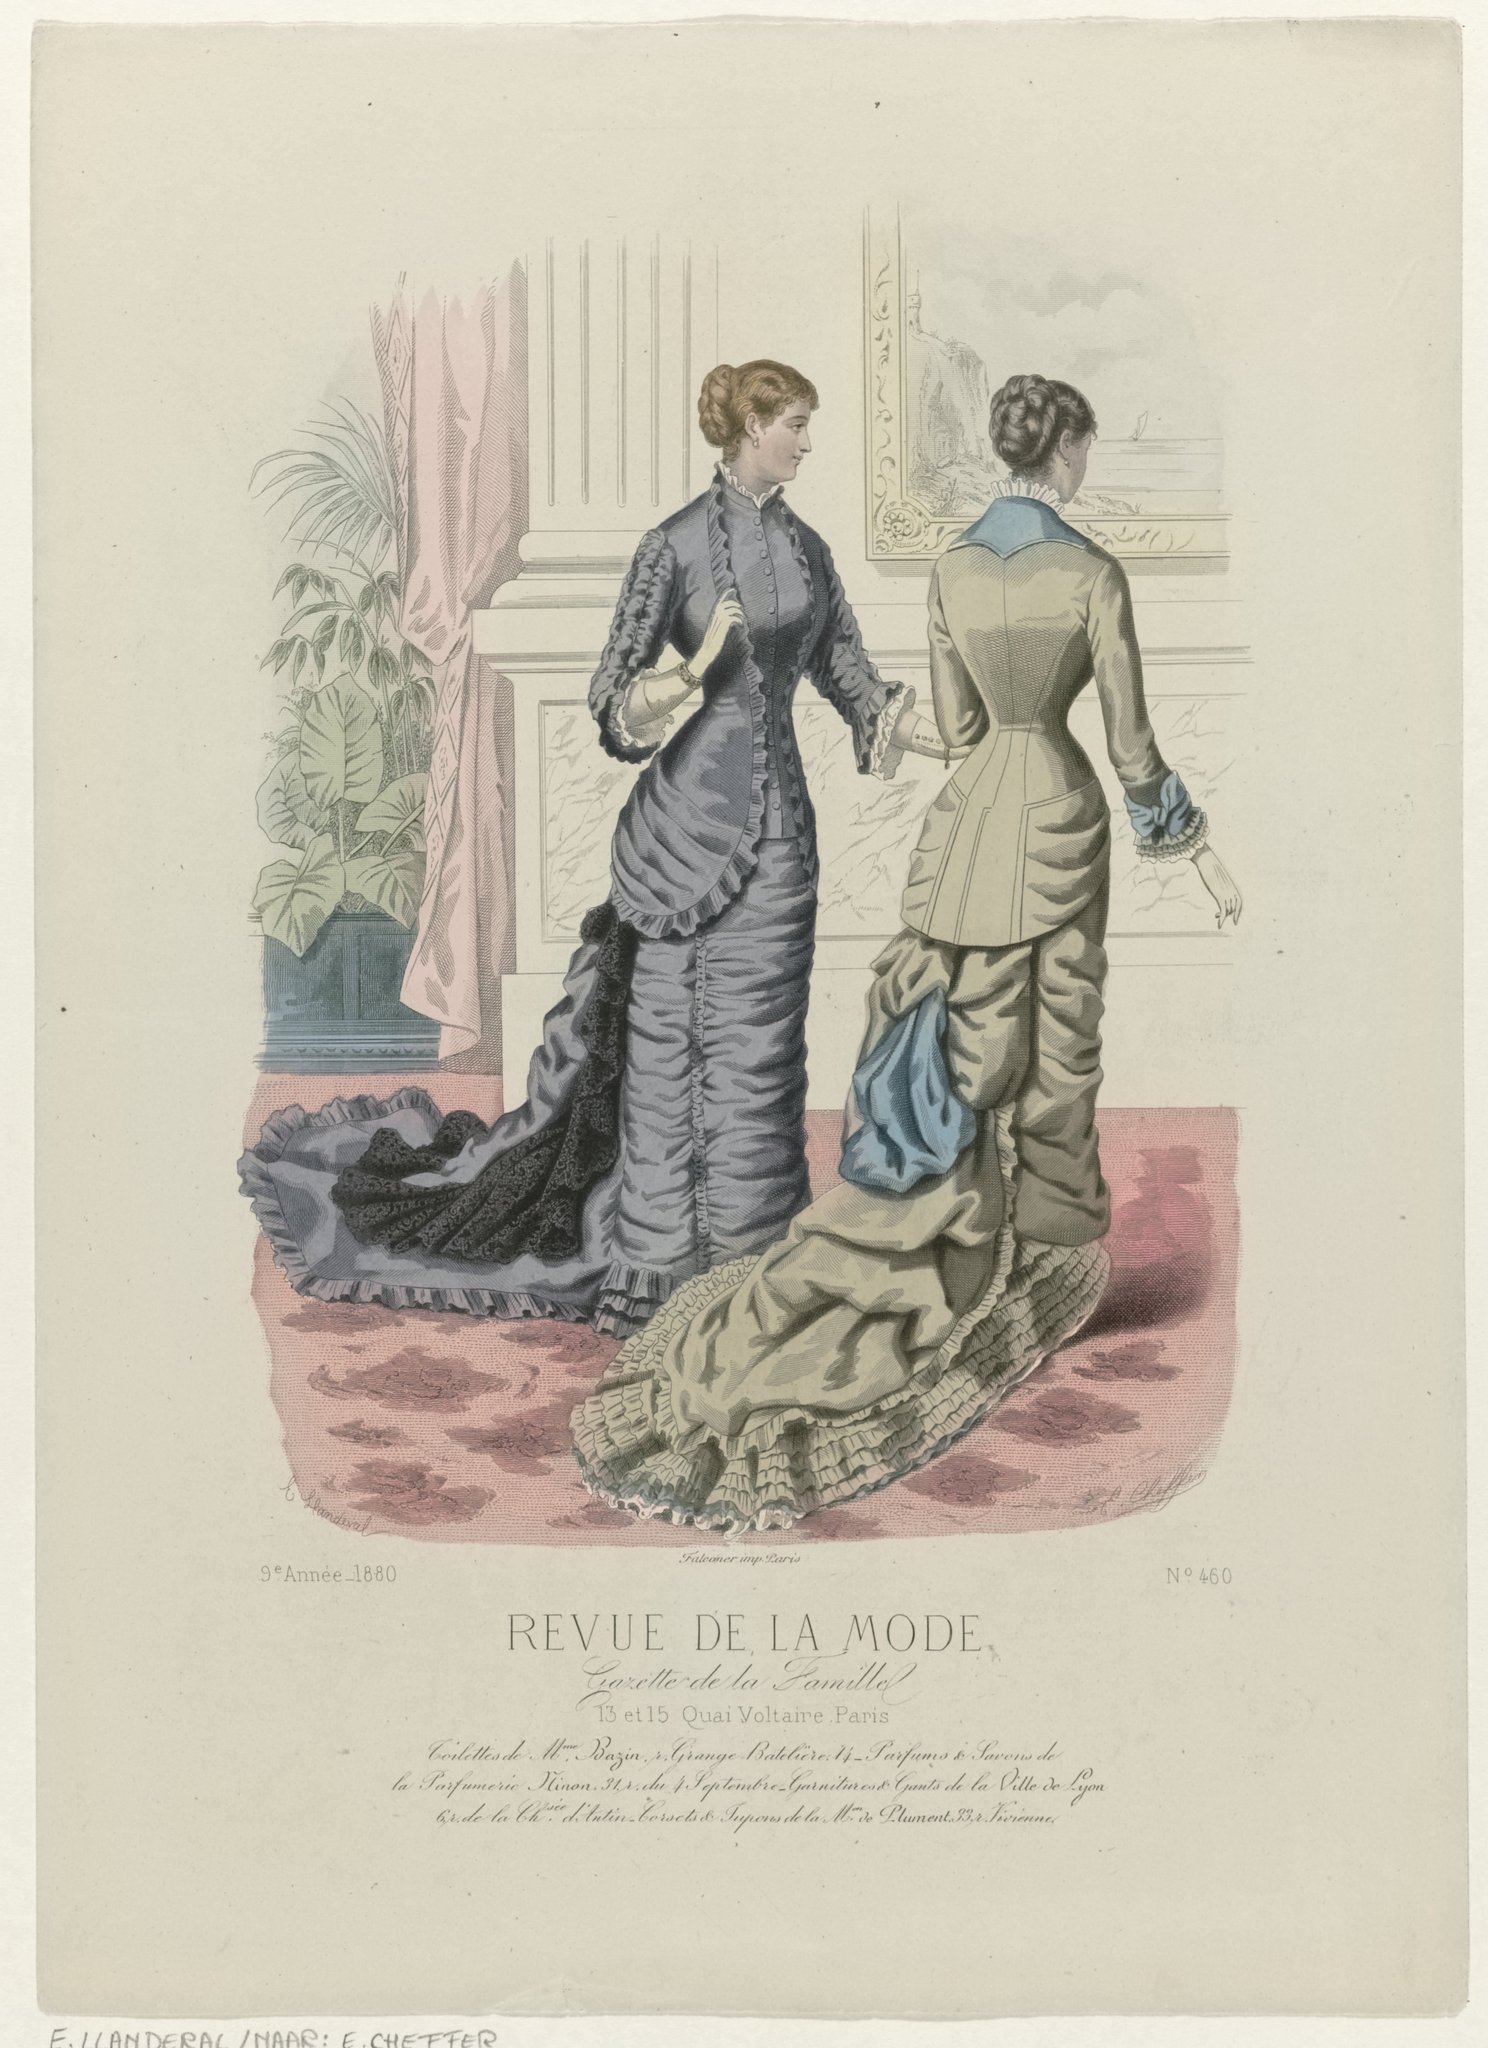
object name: fashion print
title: Revue de la Mode, Gazette de la Famille, dimanche 24 octobre 1880, 9e année, No. 460: Toilettes de la Mme Bazin (...)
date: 1880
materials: paper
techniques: engraving, hand coloring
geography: paris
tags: gloves, mittens (long gloves) (+ women's clothes), lace (+ women's clothes), fashion plates, skirt (+ women's clothes), dress, gown (+ women's clothes), bracelet, wristlet (+ women's clothes)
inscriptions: caption: ‘Toilettes de M.me Bazin,r. Grange-Batelière, 14_Parfums & Savons de la Parfumerie Ninon, 31, r. du 4 Septembre_Garnitures & Gants de la Ville de Lyon, 6. r. de la Ch.sée d'Antin_ Corsets & Jupons de la M.on de Plument. 33. r. Vivienne.’, address: ‘13 et 15, Quai Voltaire, Paris’, title: ‘REVUE DE LA MODE / Gazette de la Famille’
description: Twee vrouwen in een interieur, in japonnen van Bazin. Links: japon van zwart satijn en zwarte kant. Rechts: japon van beige- en lichtblauwe 'satin merveilleux' en 'satin de Lyon'. Onder de afbeelding enkele regels reclametekst voor verschillende producten. Prent uit het modetijdschrift Revue de la Mode (1872-1913). Uitgebreide beschrijving van de kleding op pagina 355 en 356 "PLANCHE COLORIÉE".